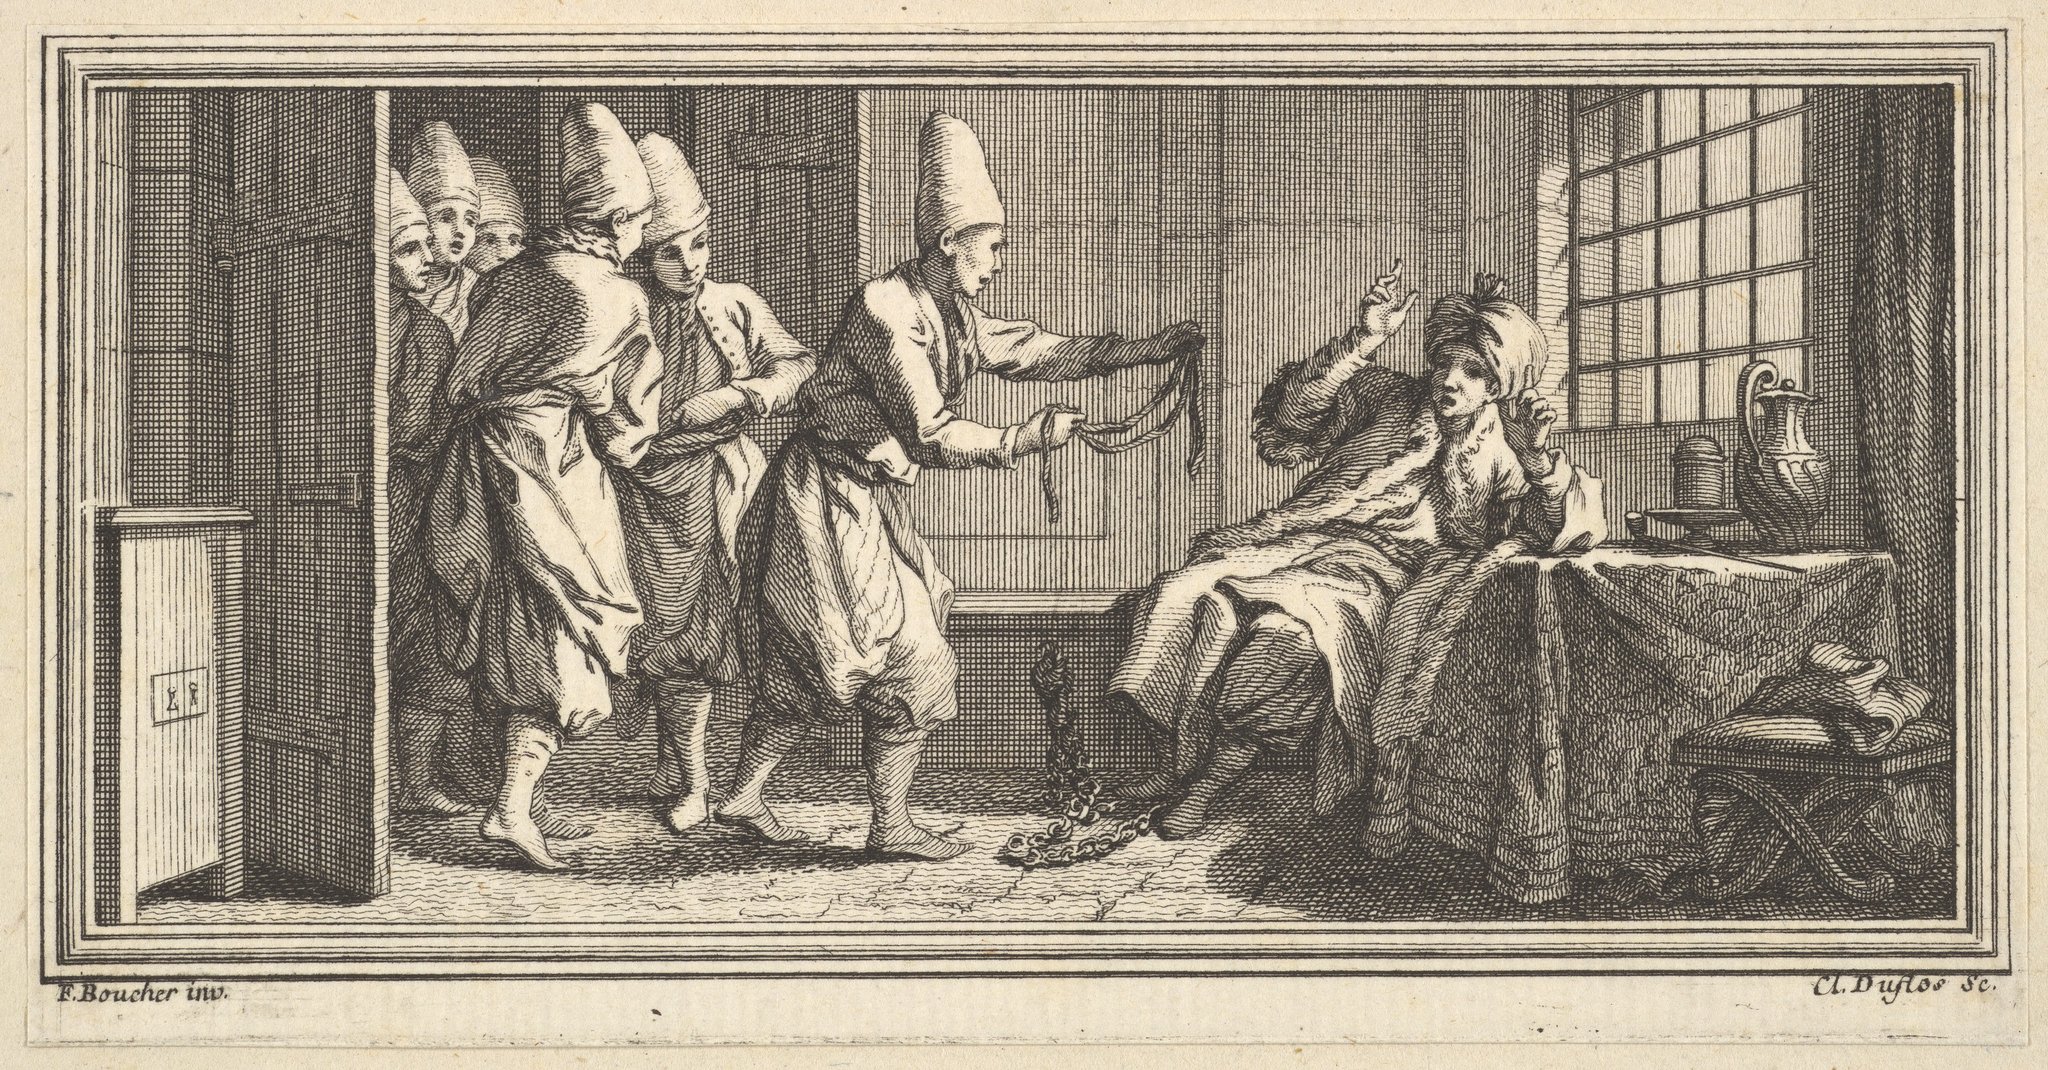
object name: print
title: Bringing Rope to the Prisoner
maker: claude augustin duflos le jeune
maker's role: artist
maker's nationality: french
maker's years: 1700-1786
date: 1746-1747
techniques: engraving, etching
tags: prisoners,men